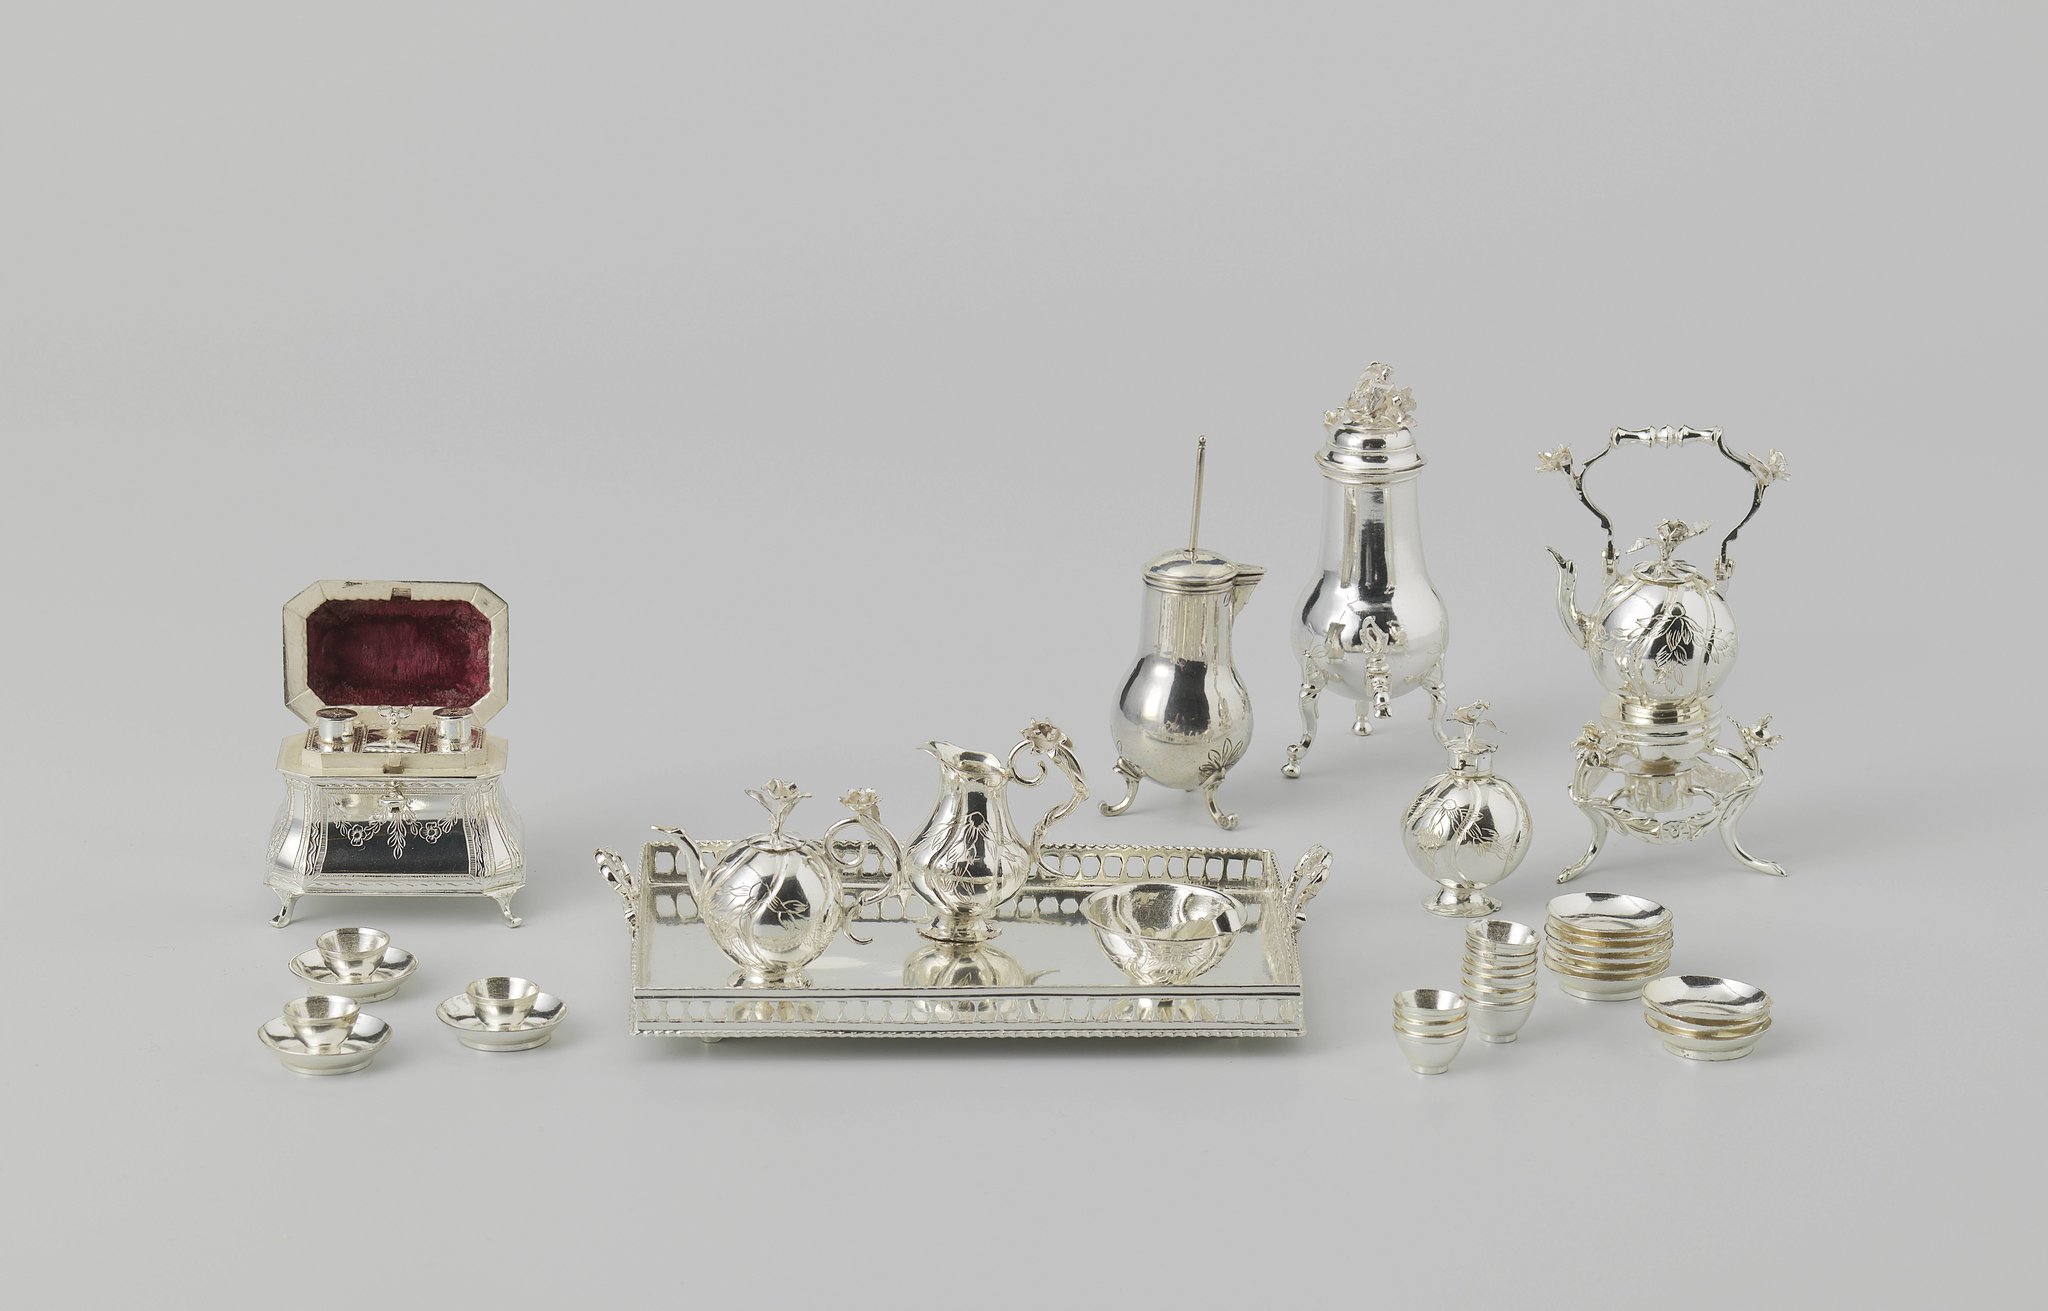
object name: miniature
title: Kop-en-schotel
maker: Anonymous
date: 1775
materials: silver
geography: amsterdam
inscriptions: maker's mark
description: Trechtervormige theekop op een schotel. De schotel heeft een opstaande rand, is onversierd en gemerkt: mt.= Voet 430. De theekop is langs de bovenrand gegraveerd en is niet gemerkt. De kop en schotel worden bewaard als onderdeel van een theeservies (BK-NM-11177-142. Het theeservies heeft in het totaal twaalf kop en schotels die gelijk zijn aan dit exemplaar.